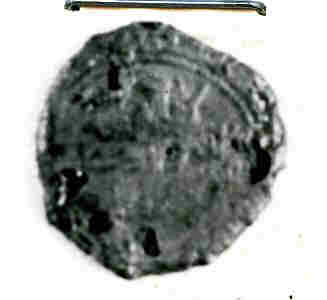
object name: coin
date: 701-833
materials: copper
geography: iran